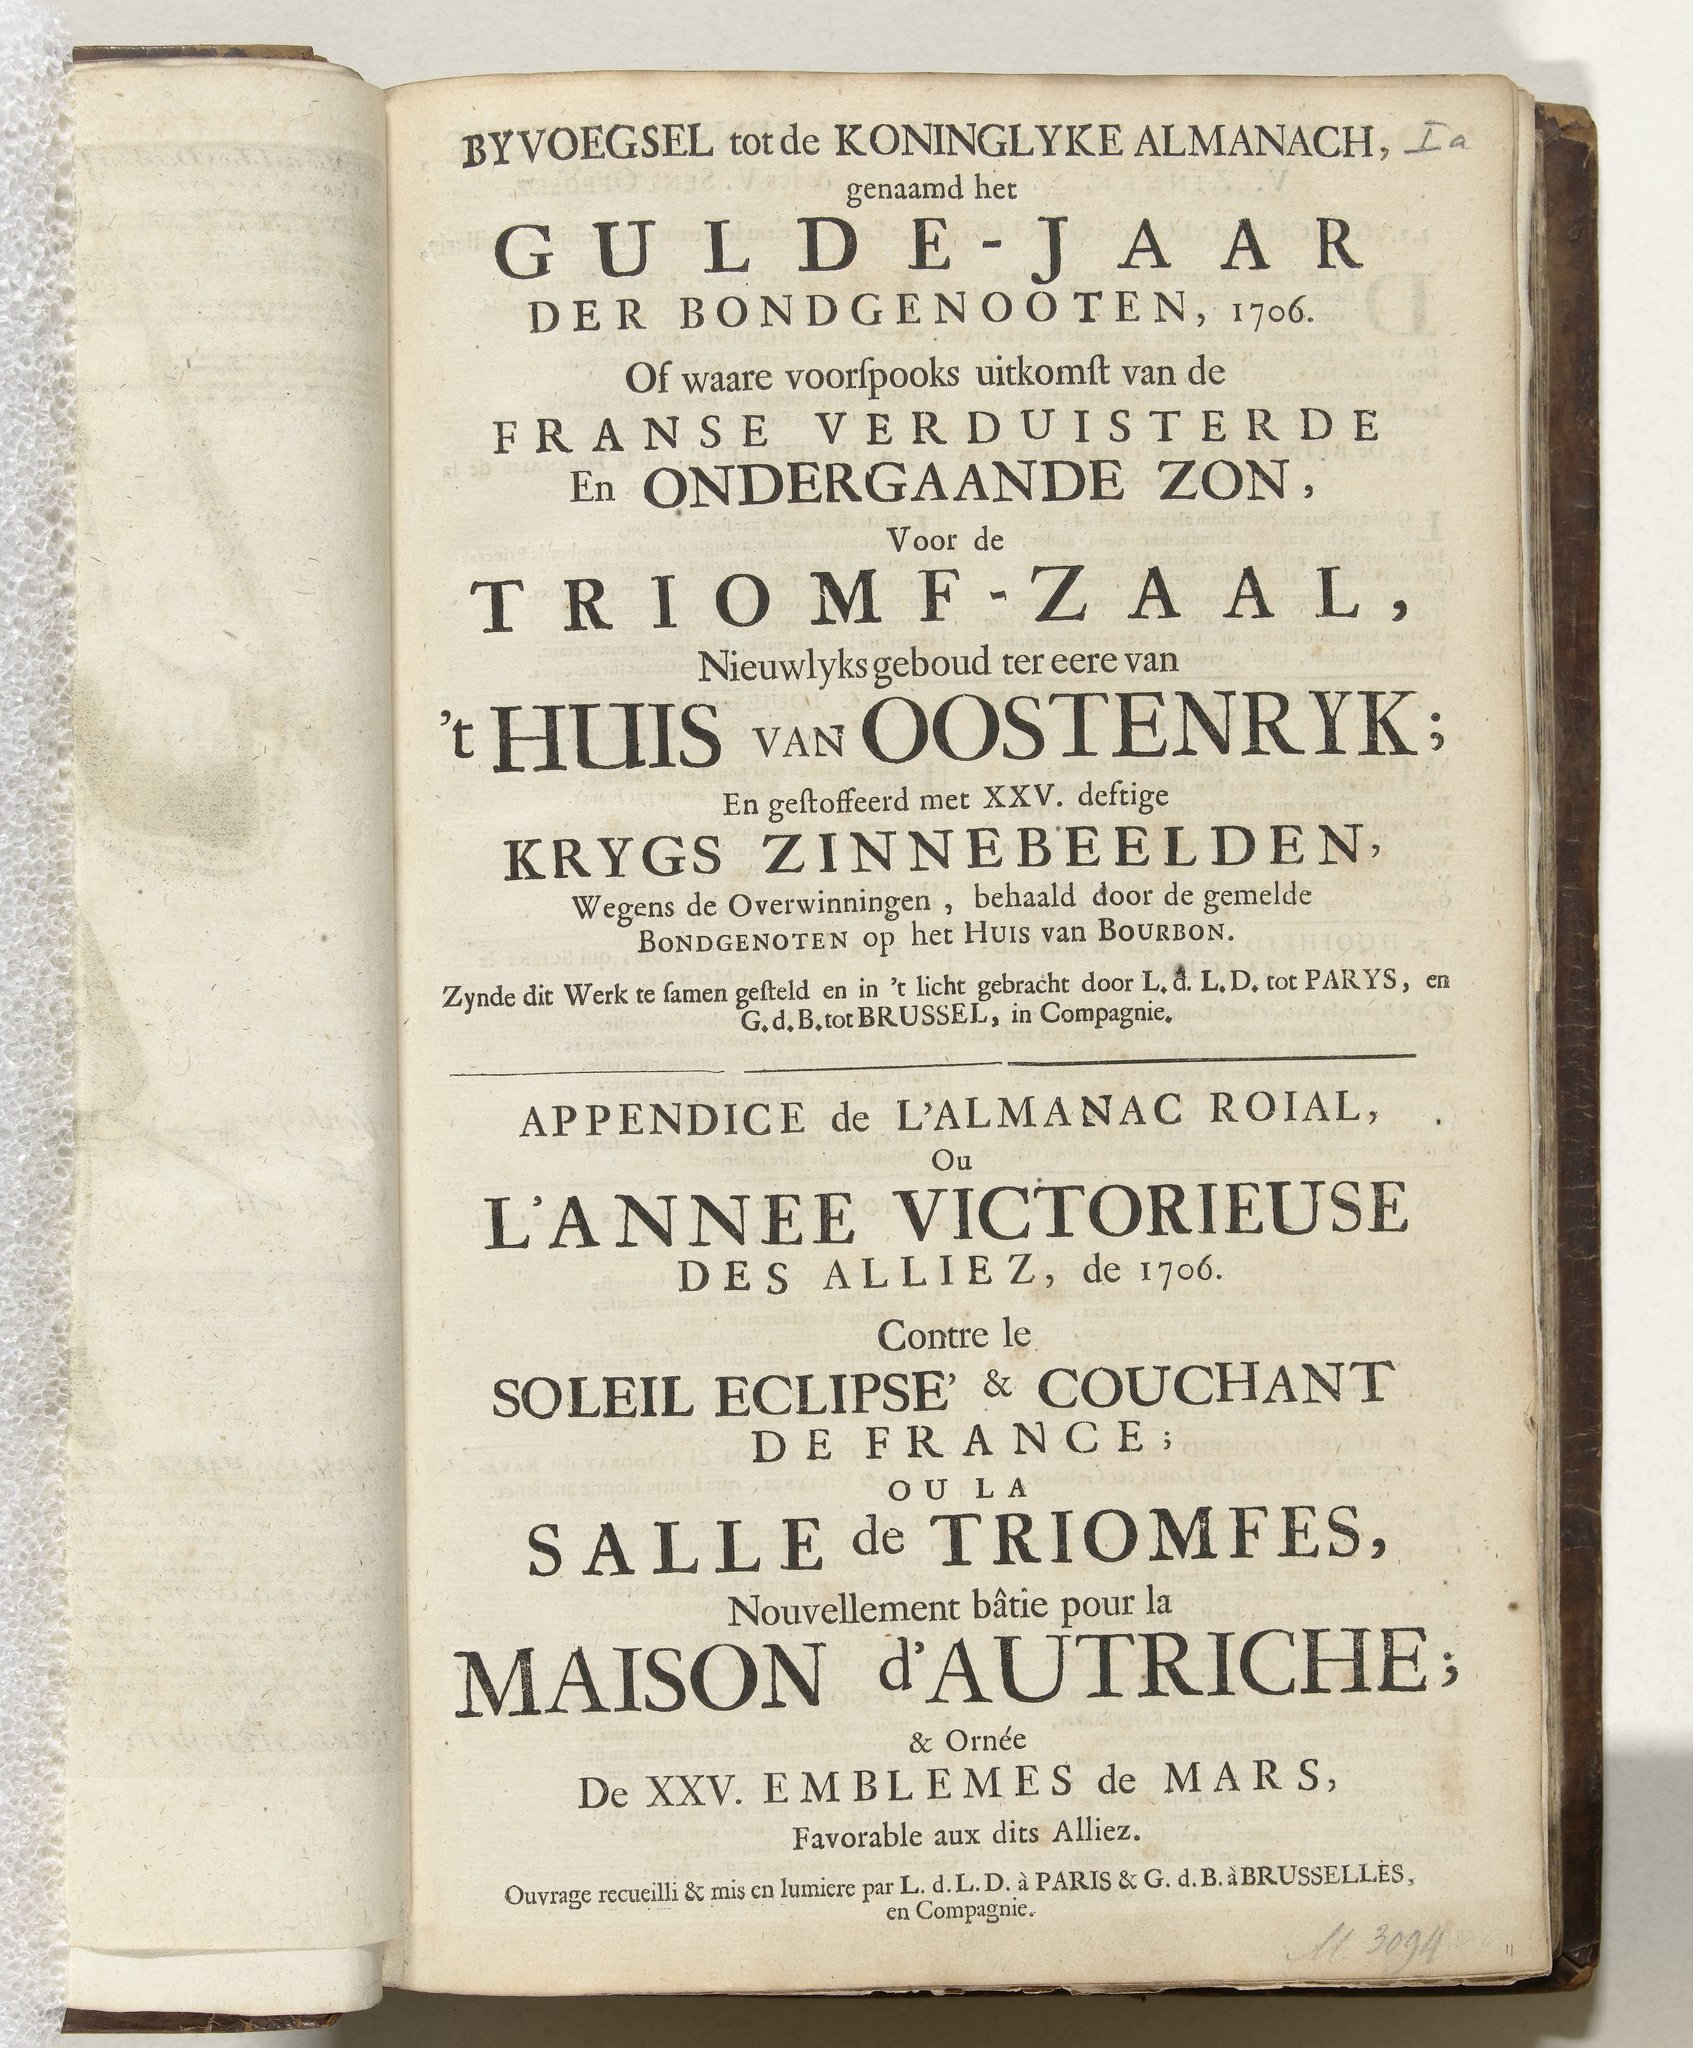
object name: titelblad, titelpagina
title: Appendice de l'Almanac Royal Ou l'Annee Victorieuse des Alliez, de 1706 (...)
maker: carel allard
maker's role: print maker, publisher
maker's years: 1648-1709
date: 1706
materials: paper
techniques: letterpress printing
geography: amsterdam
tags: spaanse successieoorlog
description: Titelpagina voor de serie Byvoegsel tot de Koninglyke Almanach, genaamd het Gulde-Jaar der Bondgenooten, 1706. Reeks van 22 platen en 3 bladen beschrijving. Onderdeel van het prentwerk uitgegeven onder de verzameltitel 't Lust-Hof van Momus met de gebundelde series van spotprenten tijdens de jaren 1701-1713 van de Spaanse Successieoorlog.